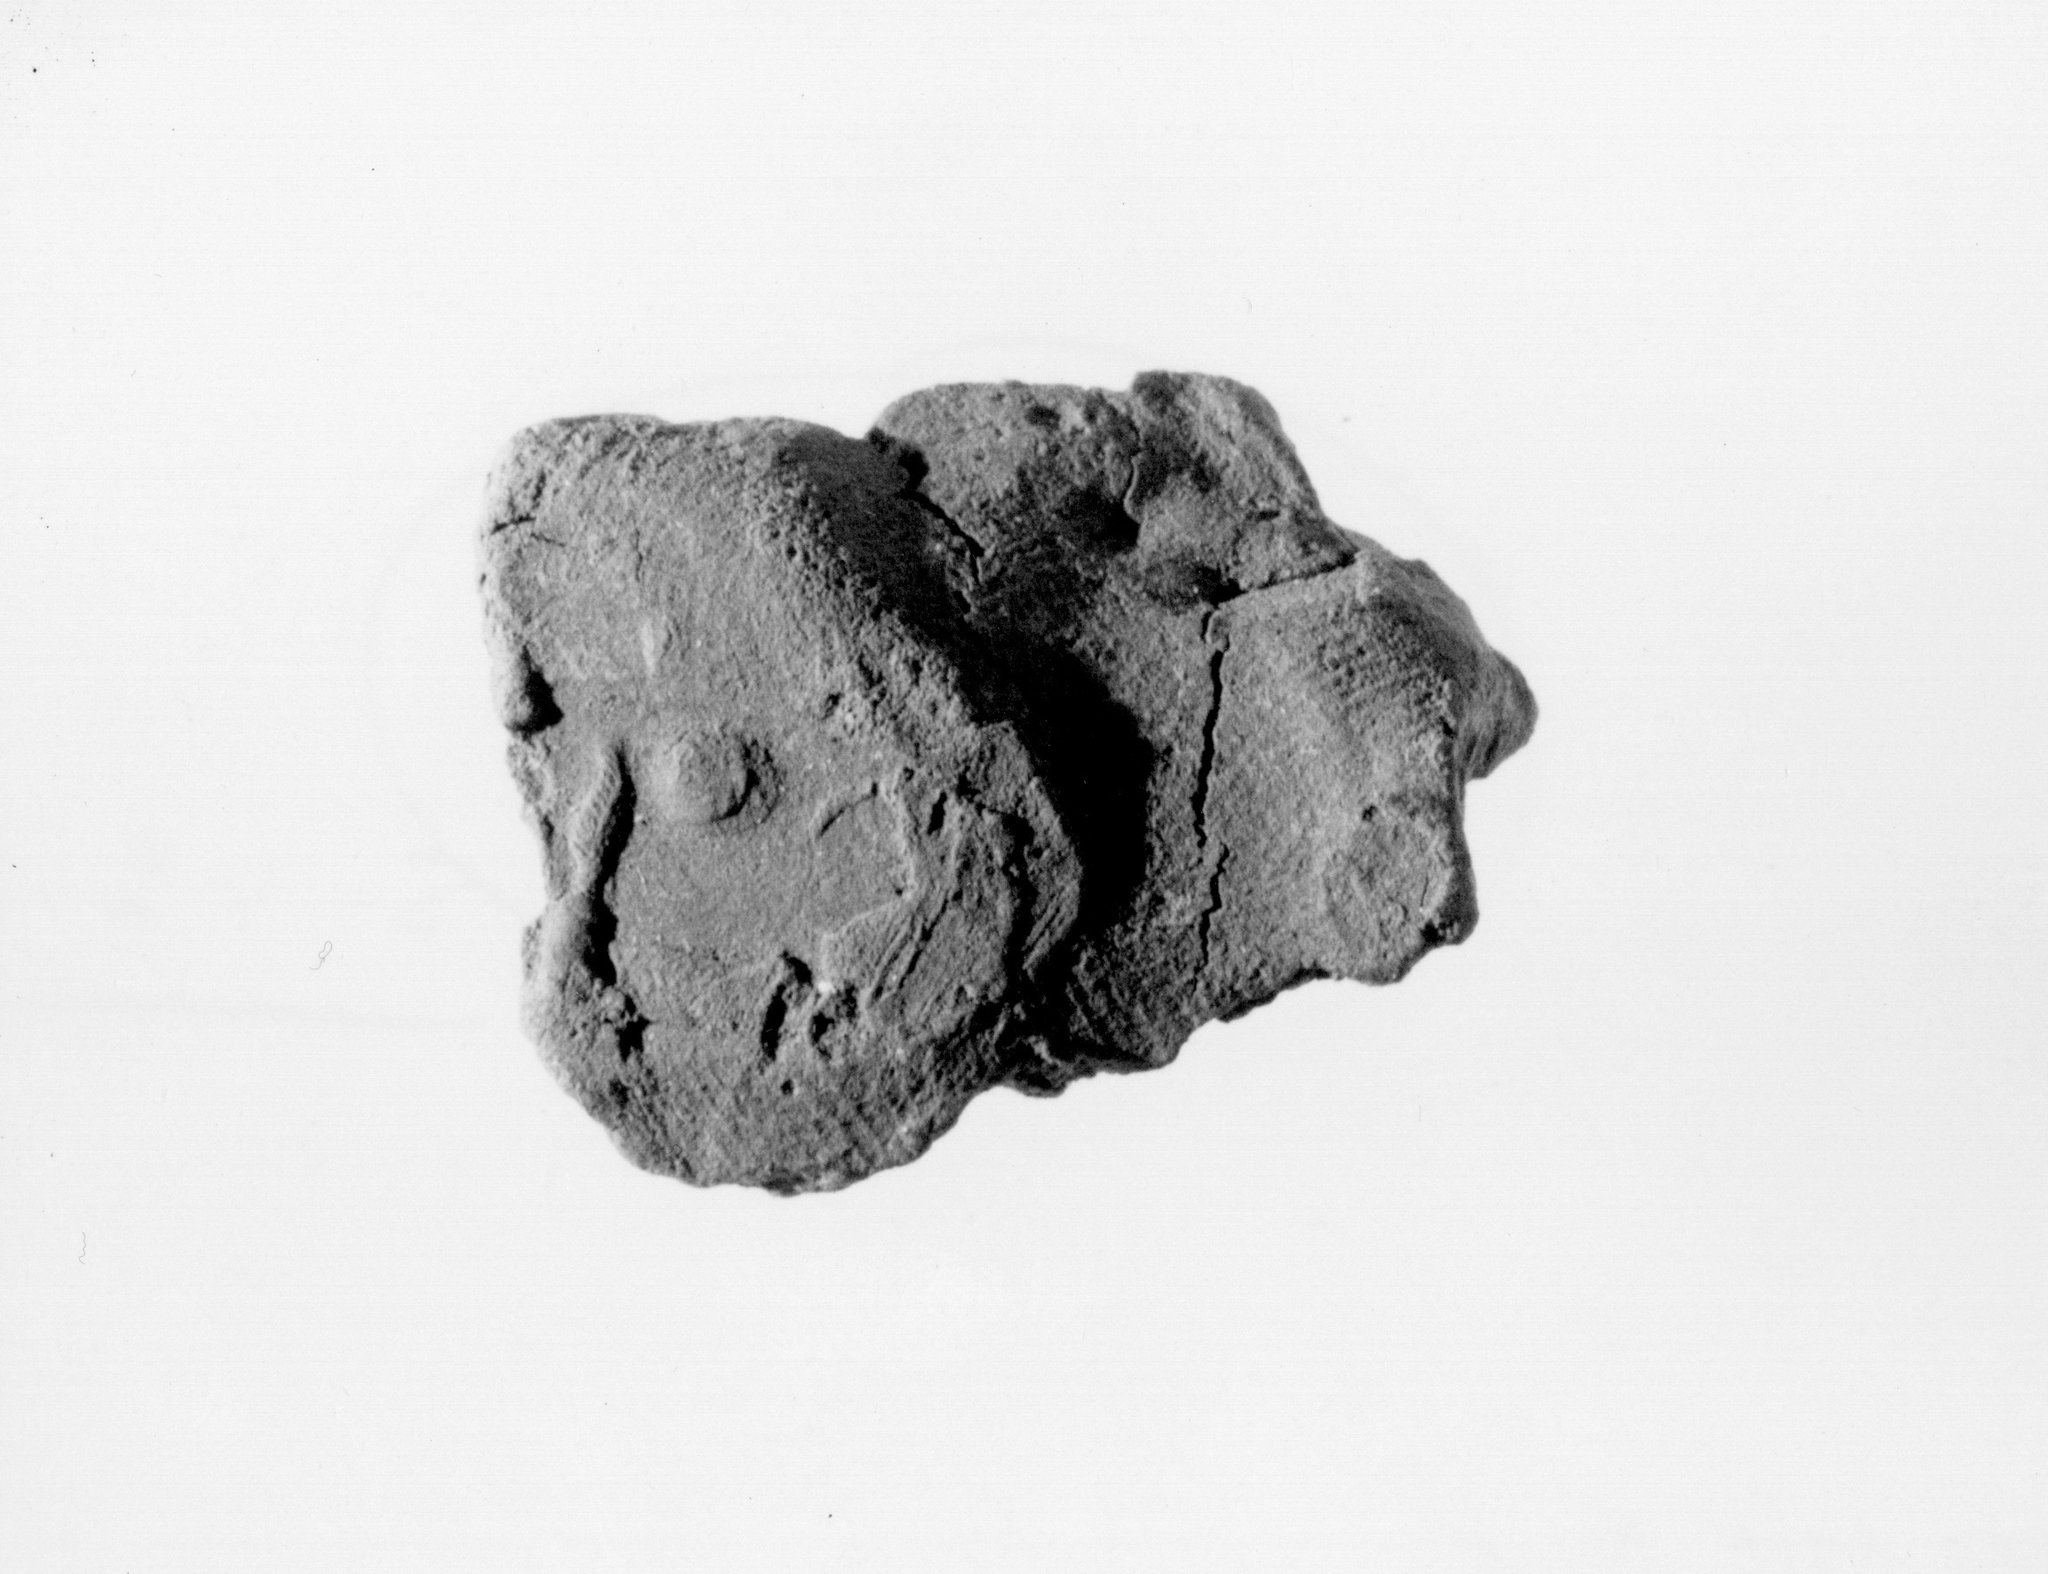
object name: sealing, nebmaatre, amenhotep iii, heb sed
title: Document Sealing With the Throne Name of Amenhotep III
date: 1390-1352 BCE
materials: mud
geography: egypt